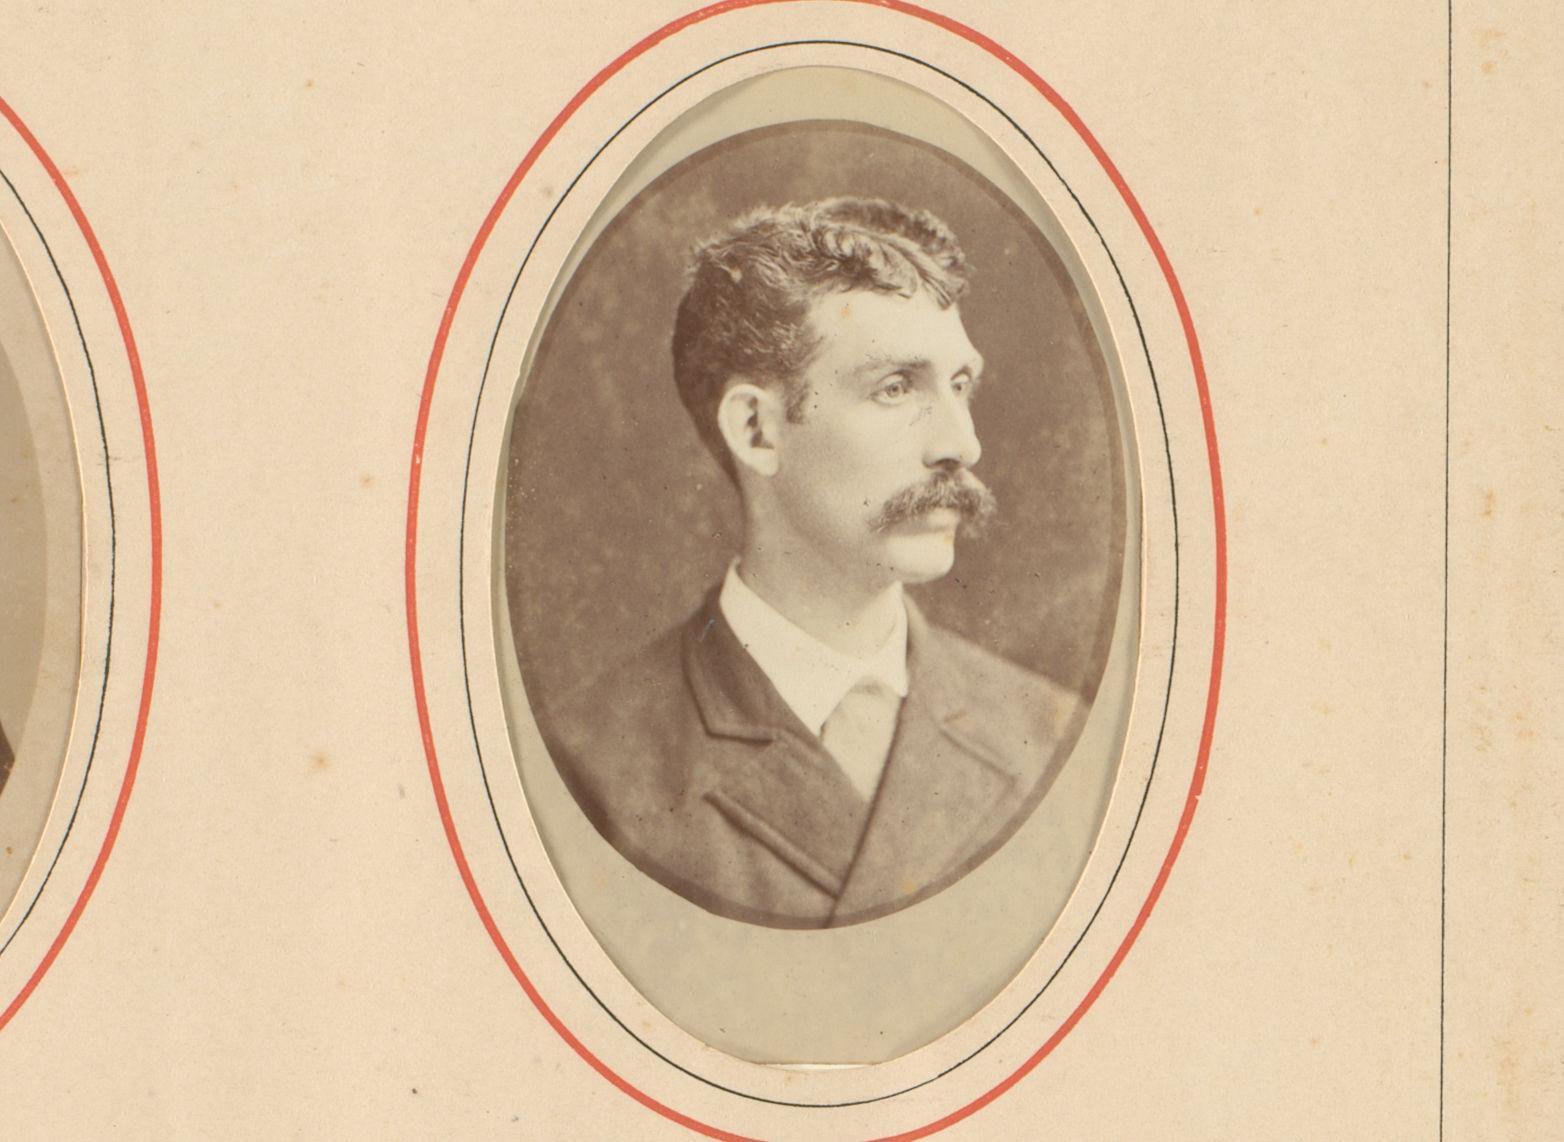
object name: photograph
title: Portret van een onbekende man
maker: Anonymous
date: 1870-1890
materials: cardboard, paper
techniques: albumen print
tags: anonymous historical person portrayed